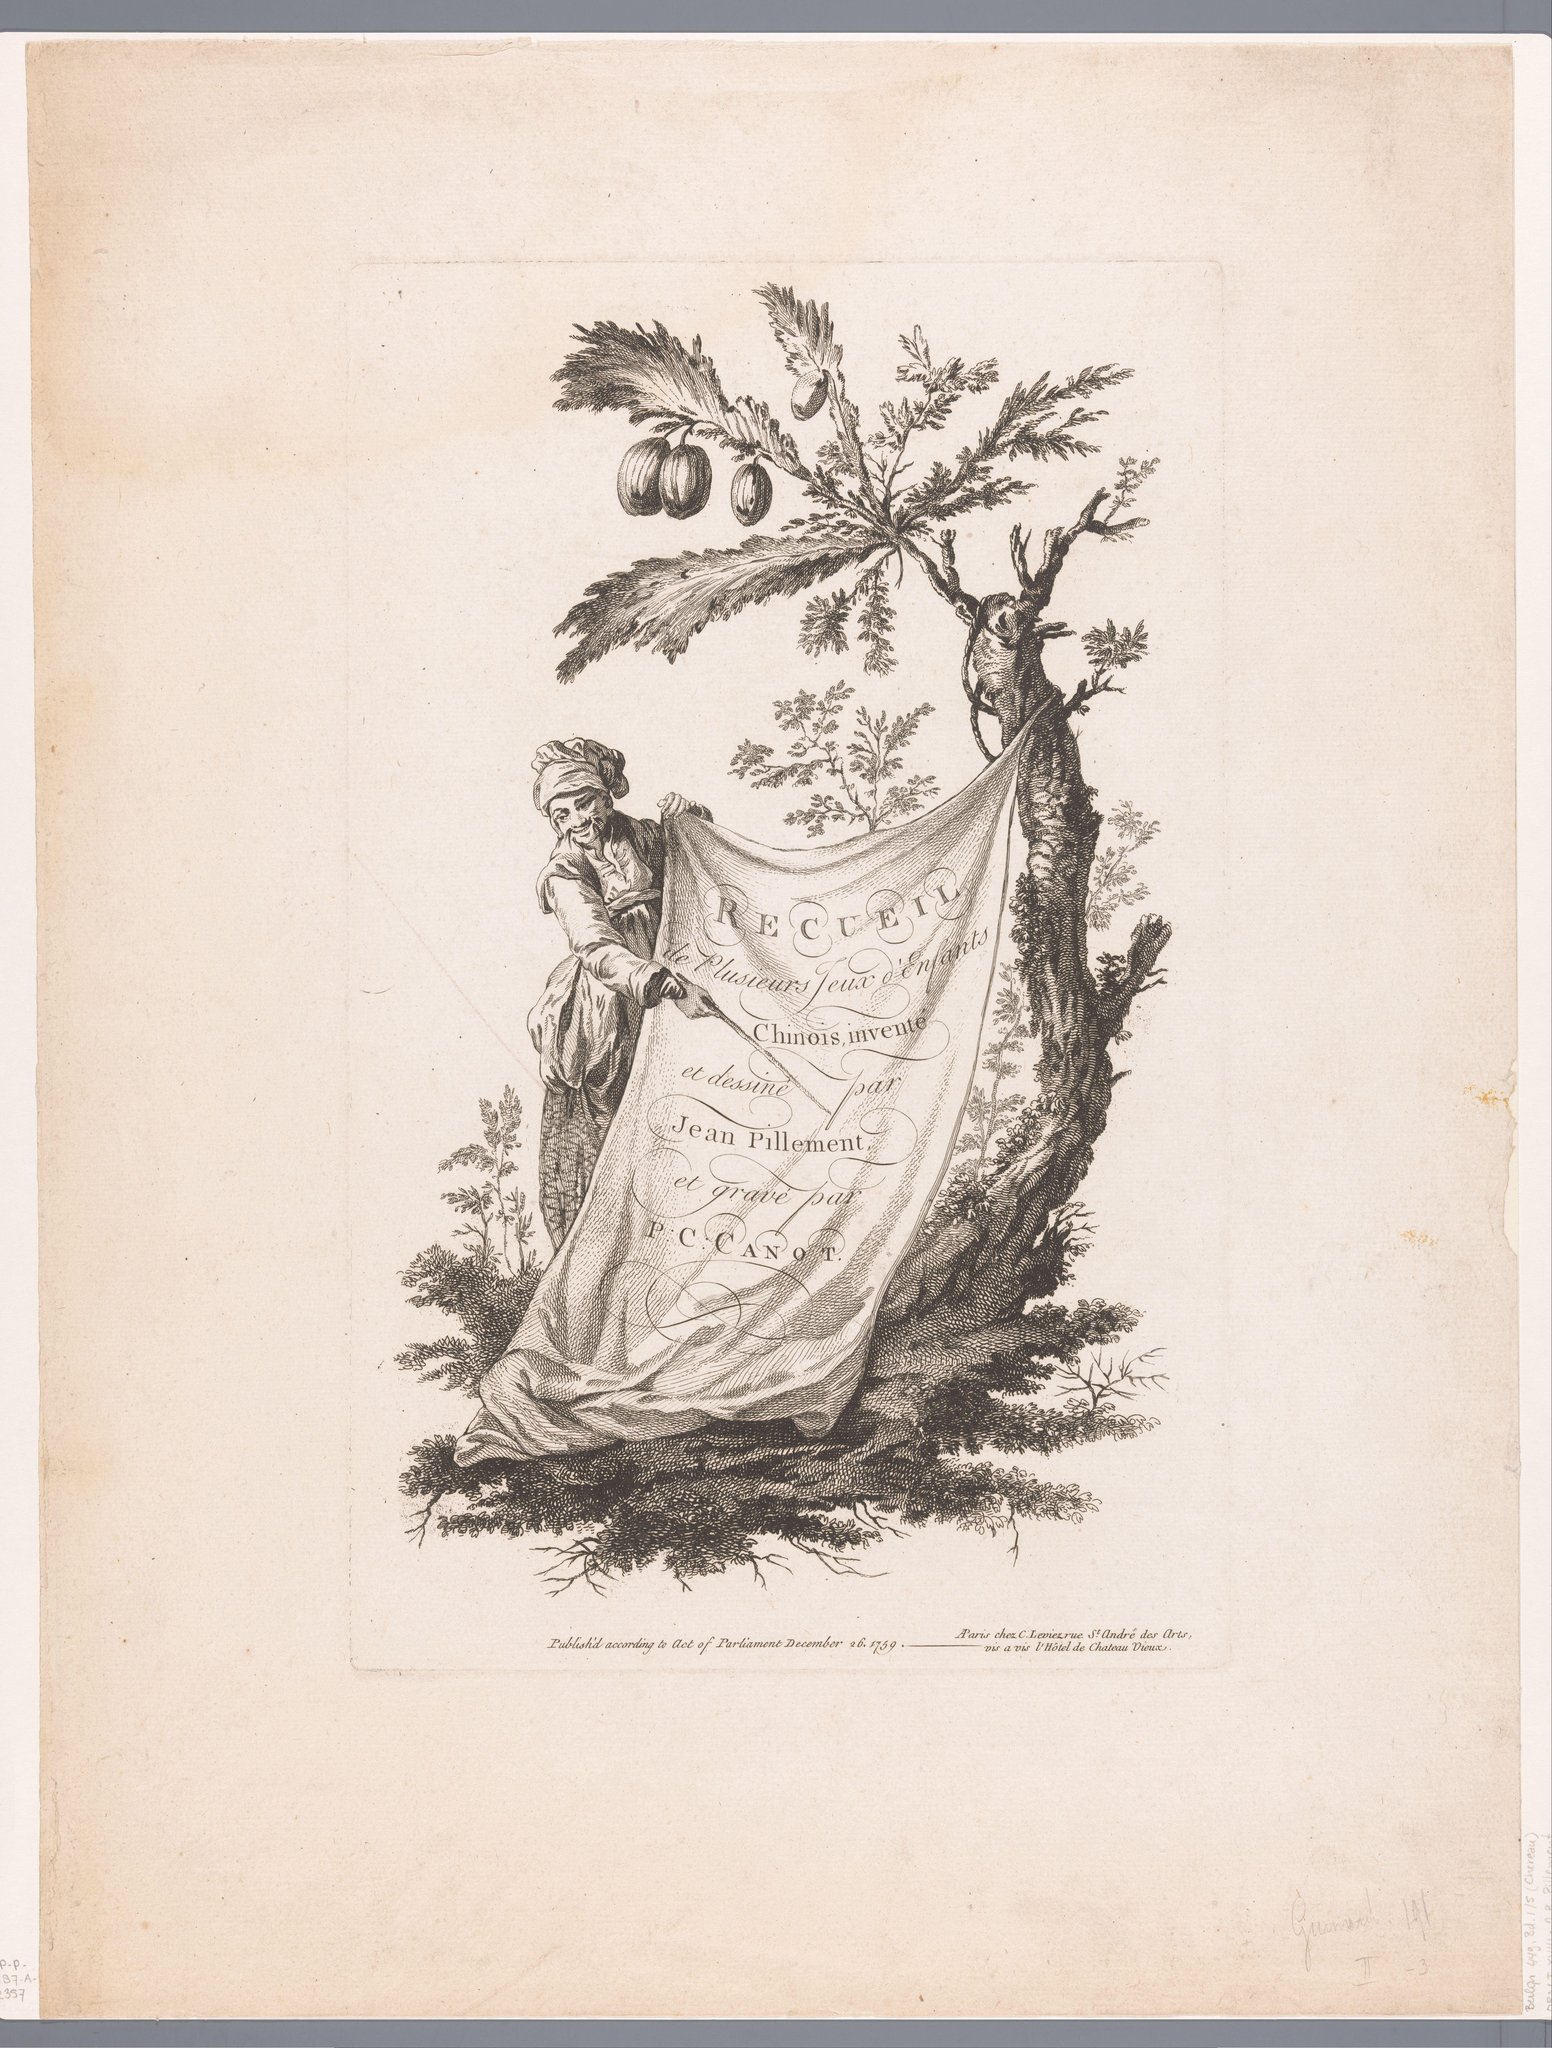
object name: titelprent, frontispice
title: Recueil de Plusieurs Jeux d'Enfants Chinois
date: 1759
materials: paper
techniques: etching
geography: paris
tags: standing figure, trees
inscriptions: collector's mark: Lugt 2228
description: Een Chinese man staat naast een boom waaraan een doek met de serietitel gebonden is. Hij houdt het doek vast en wijst ernaar met een stok.